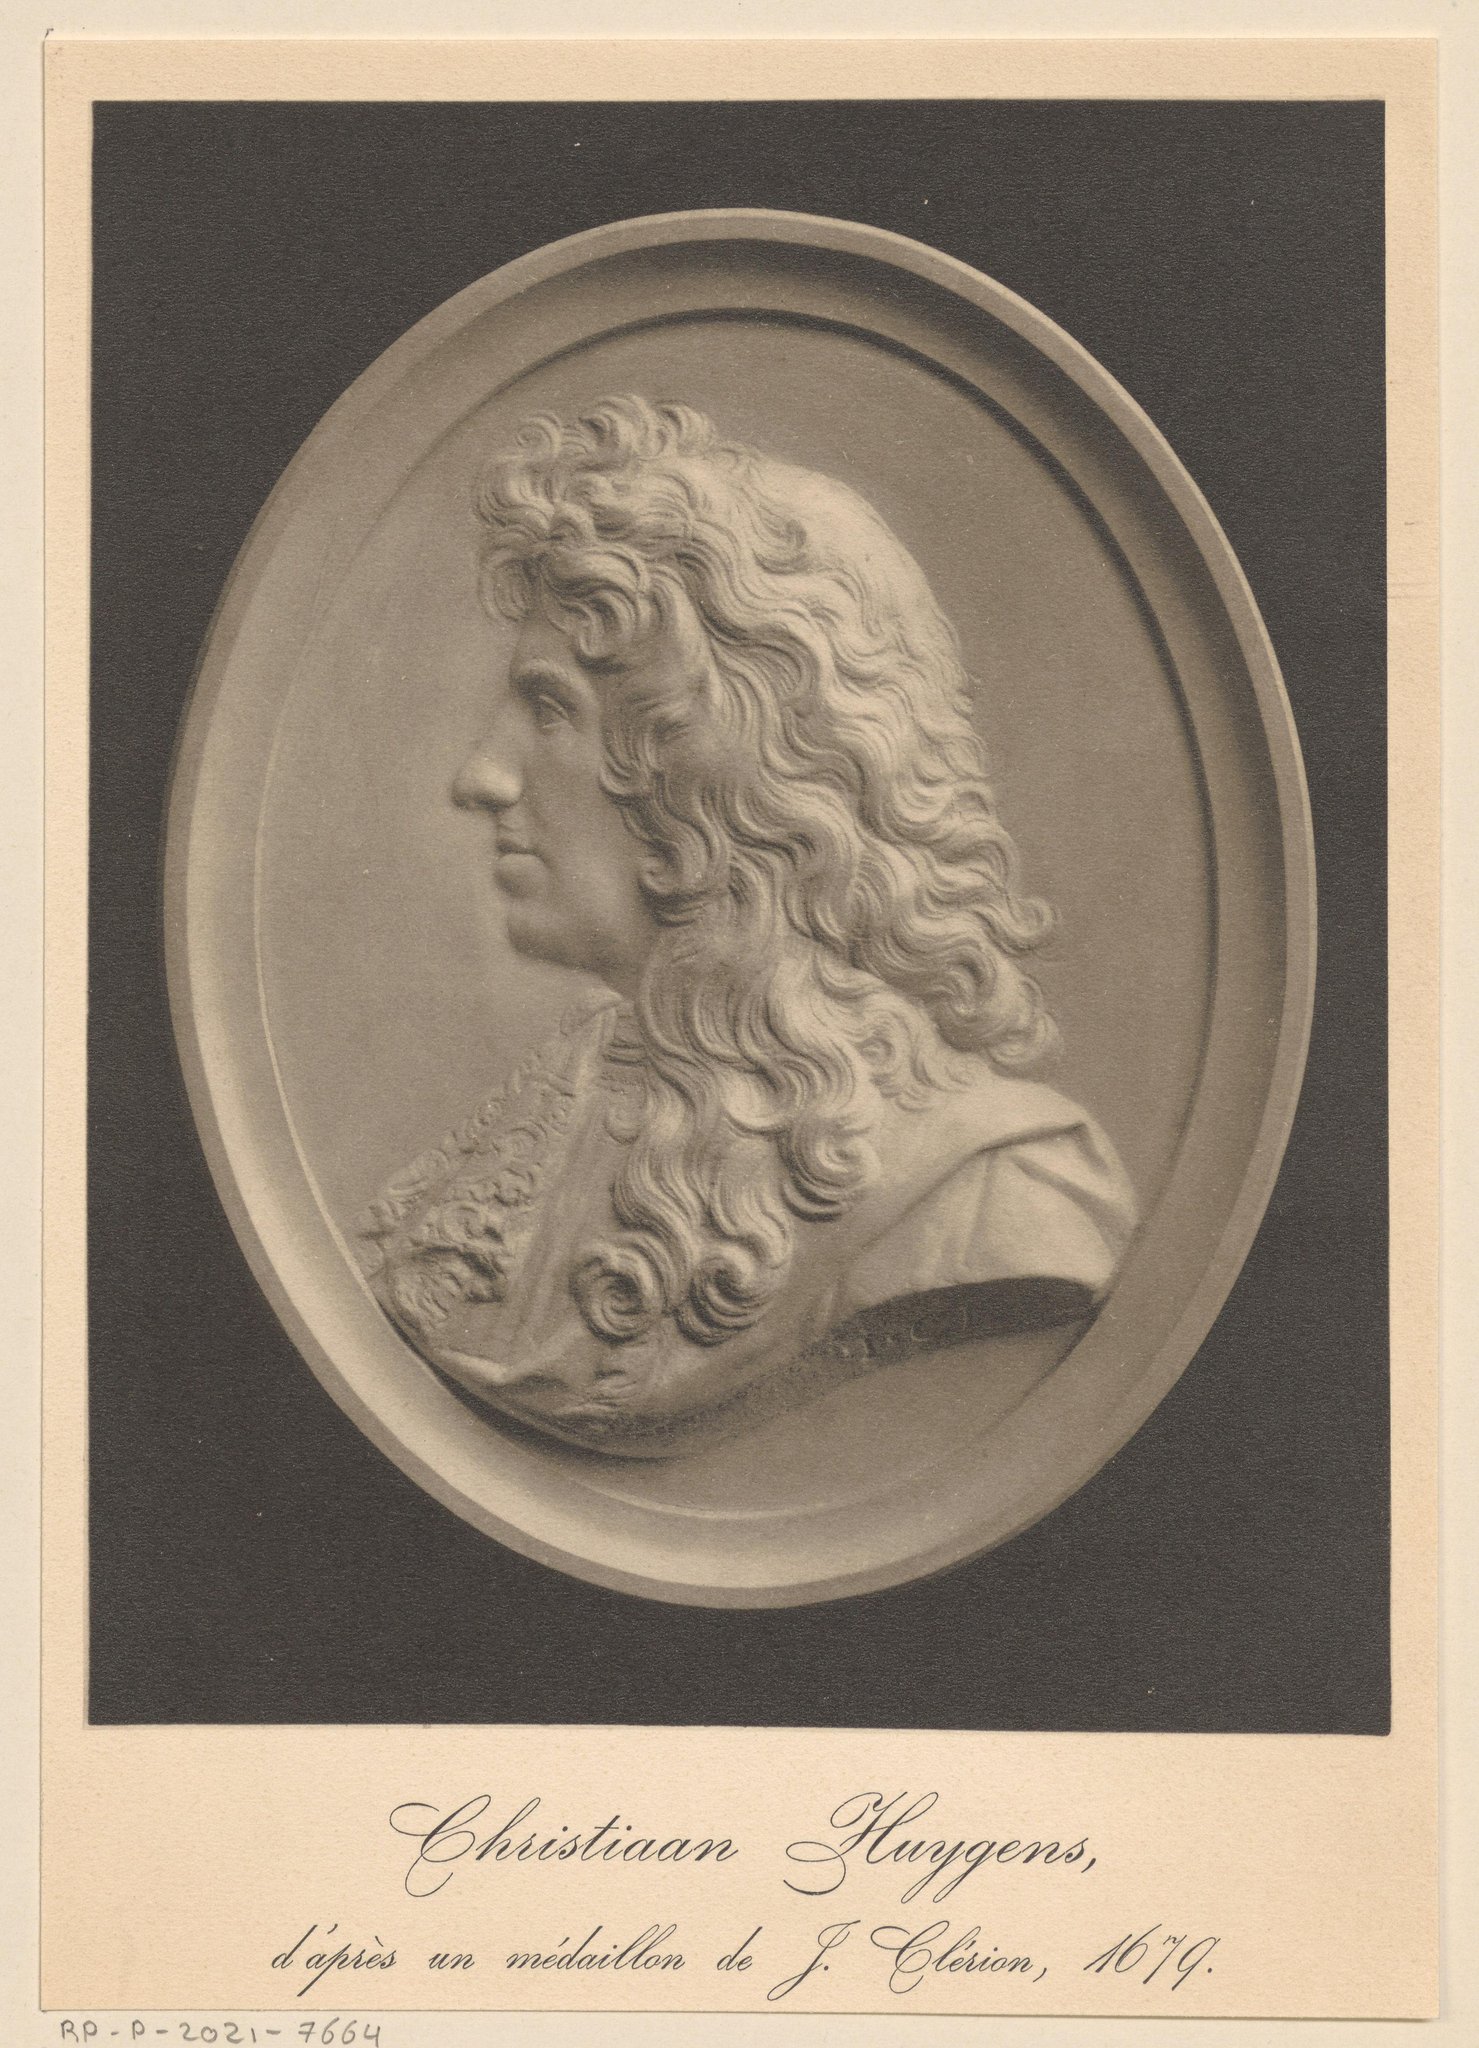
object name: photomechanical print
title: Medaillon met portret van Christiaan Huygens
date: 1875-1930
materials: paper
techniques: photograph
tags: the hague, draughtsman, physicist, christiaan huygens (ii), astronomy (and cosmography) (+ portrait of scholar, scientist), historical persons, medal (considered as a piece of sculpture, regardless of its specific function), mathematics (+ portrait of scholar, scientist)